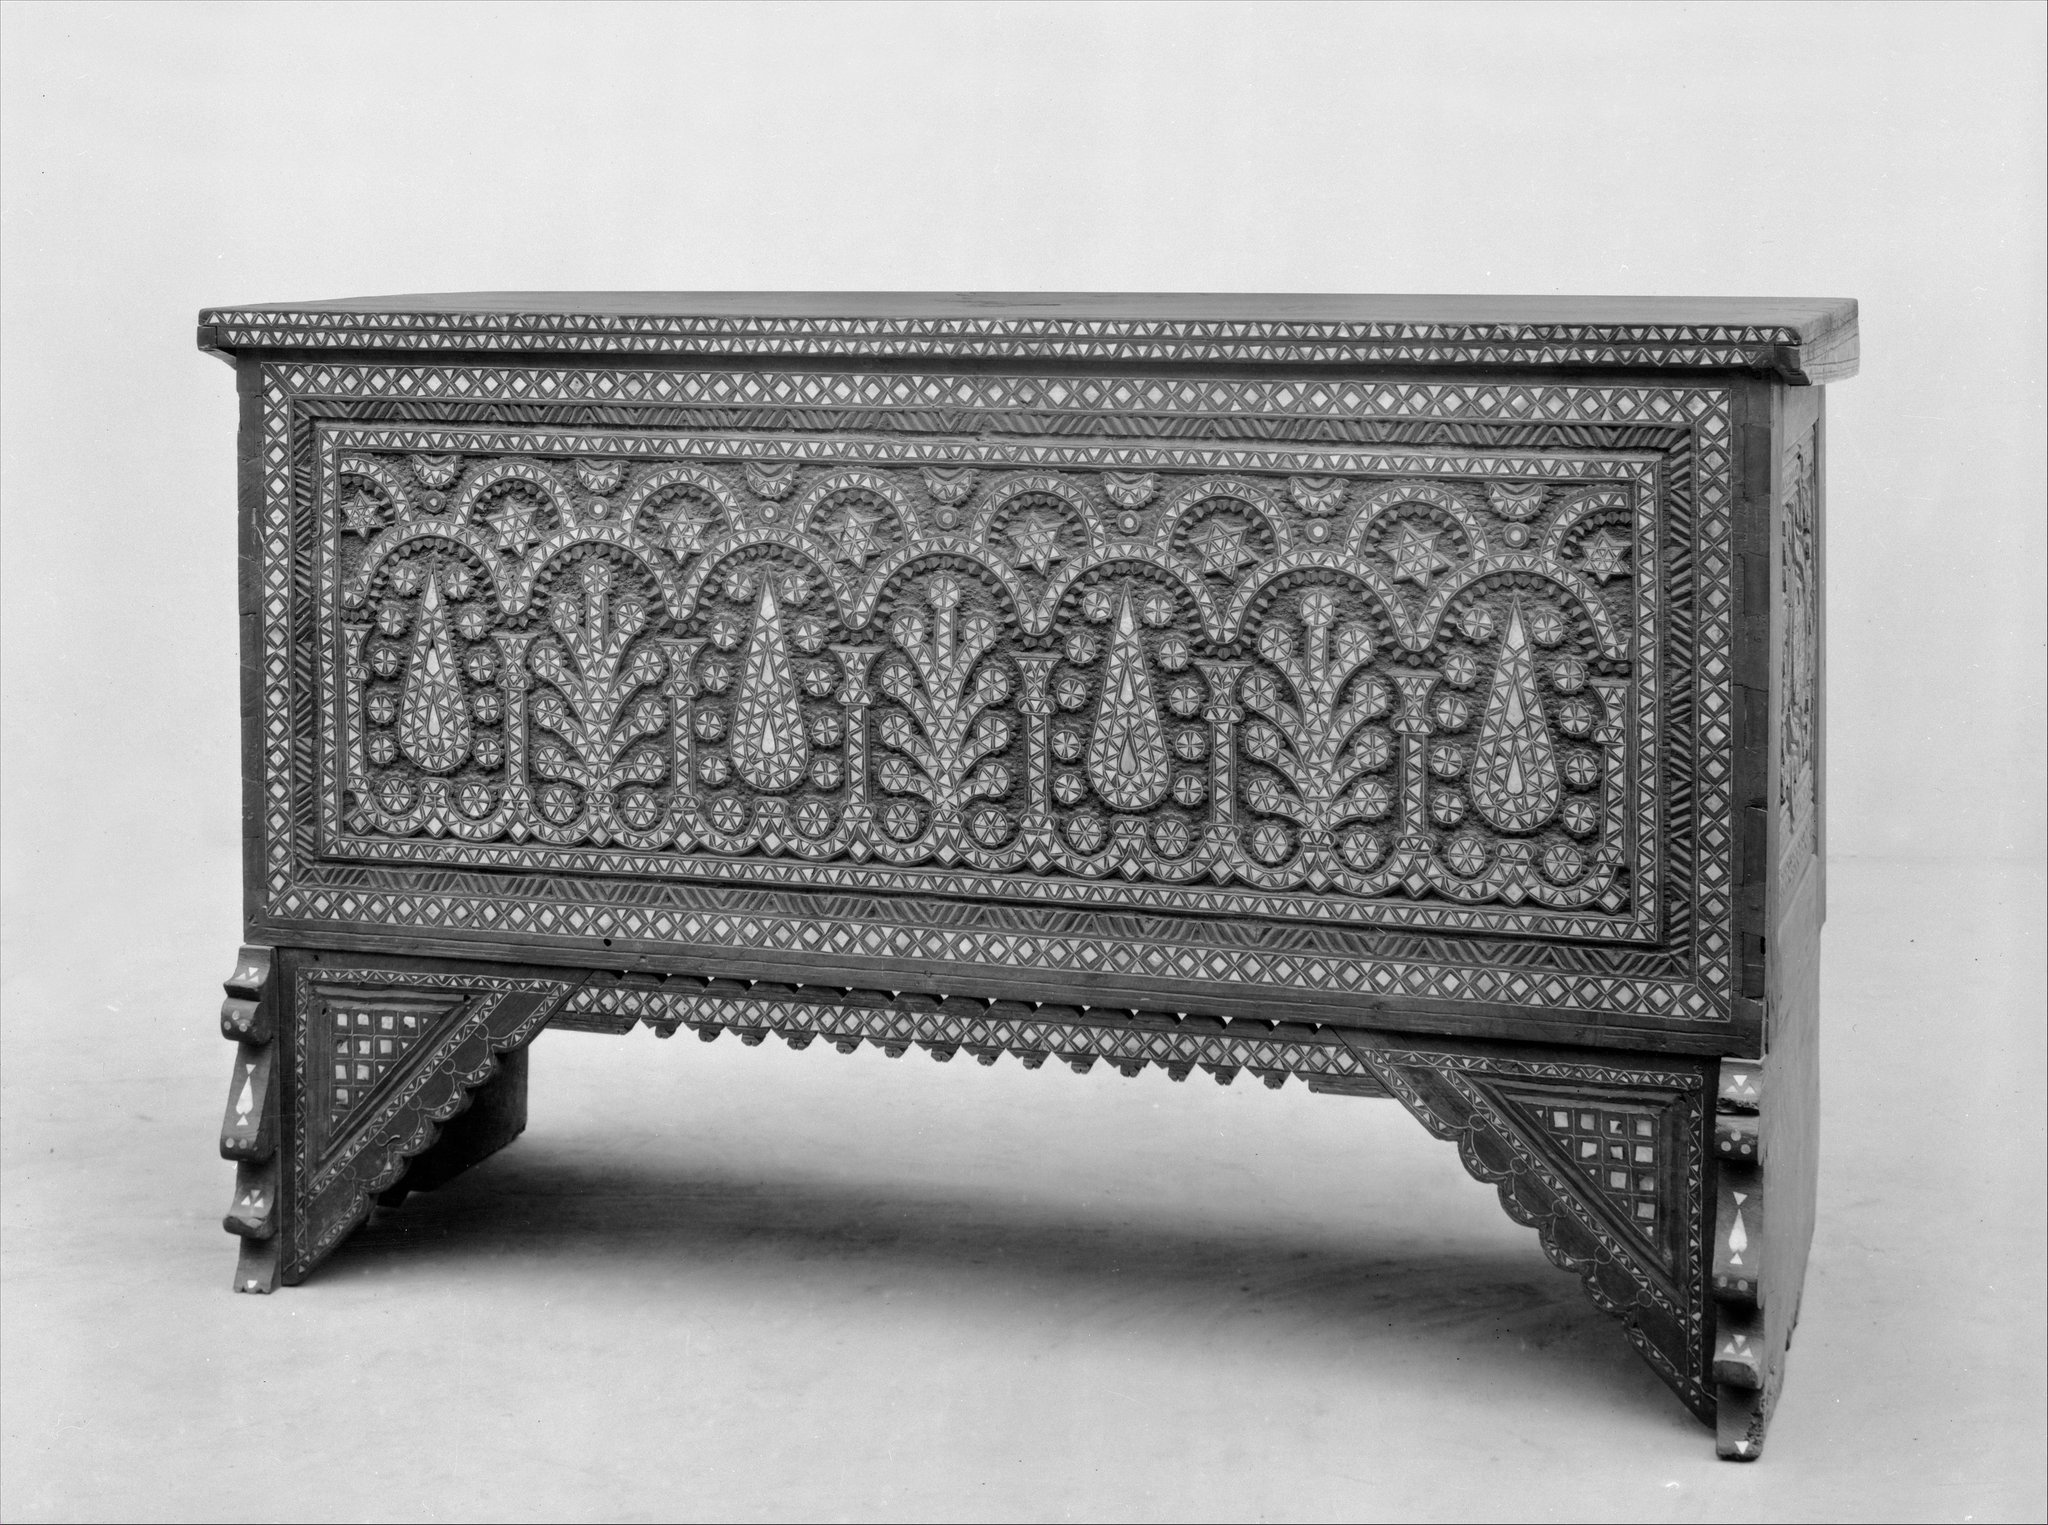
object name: chest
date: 1701-1800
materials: mother of pearl, wood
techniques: carving, inlay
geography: syria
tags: chests